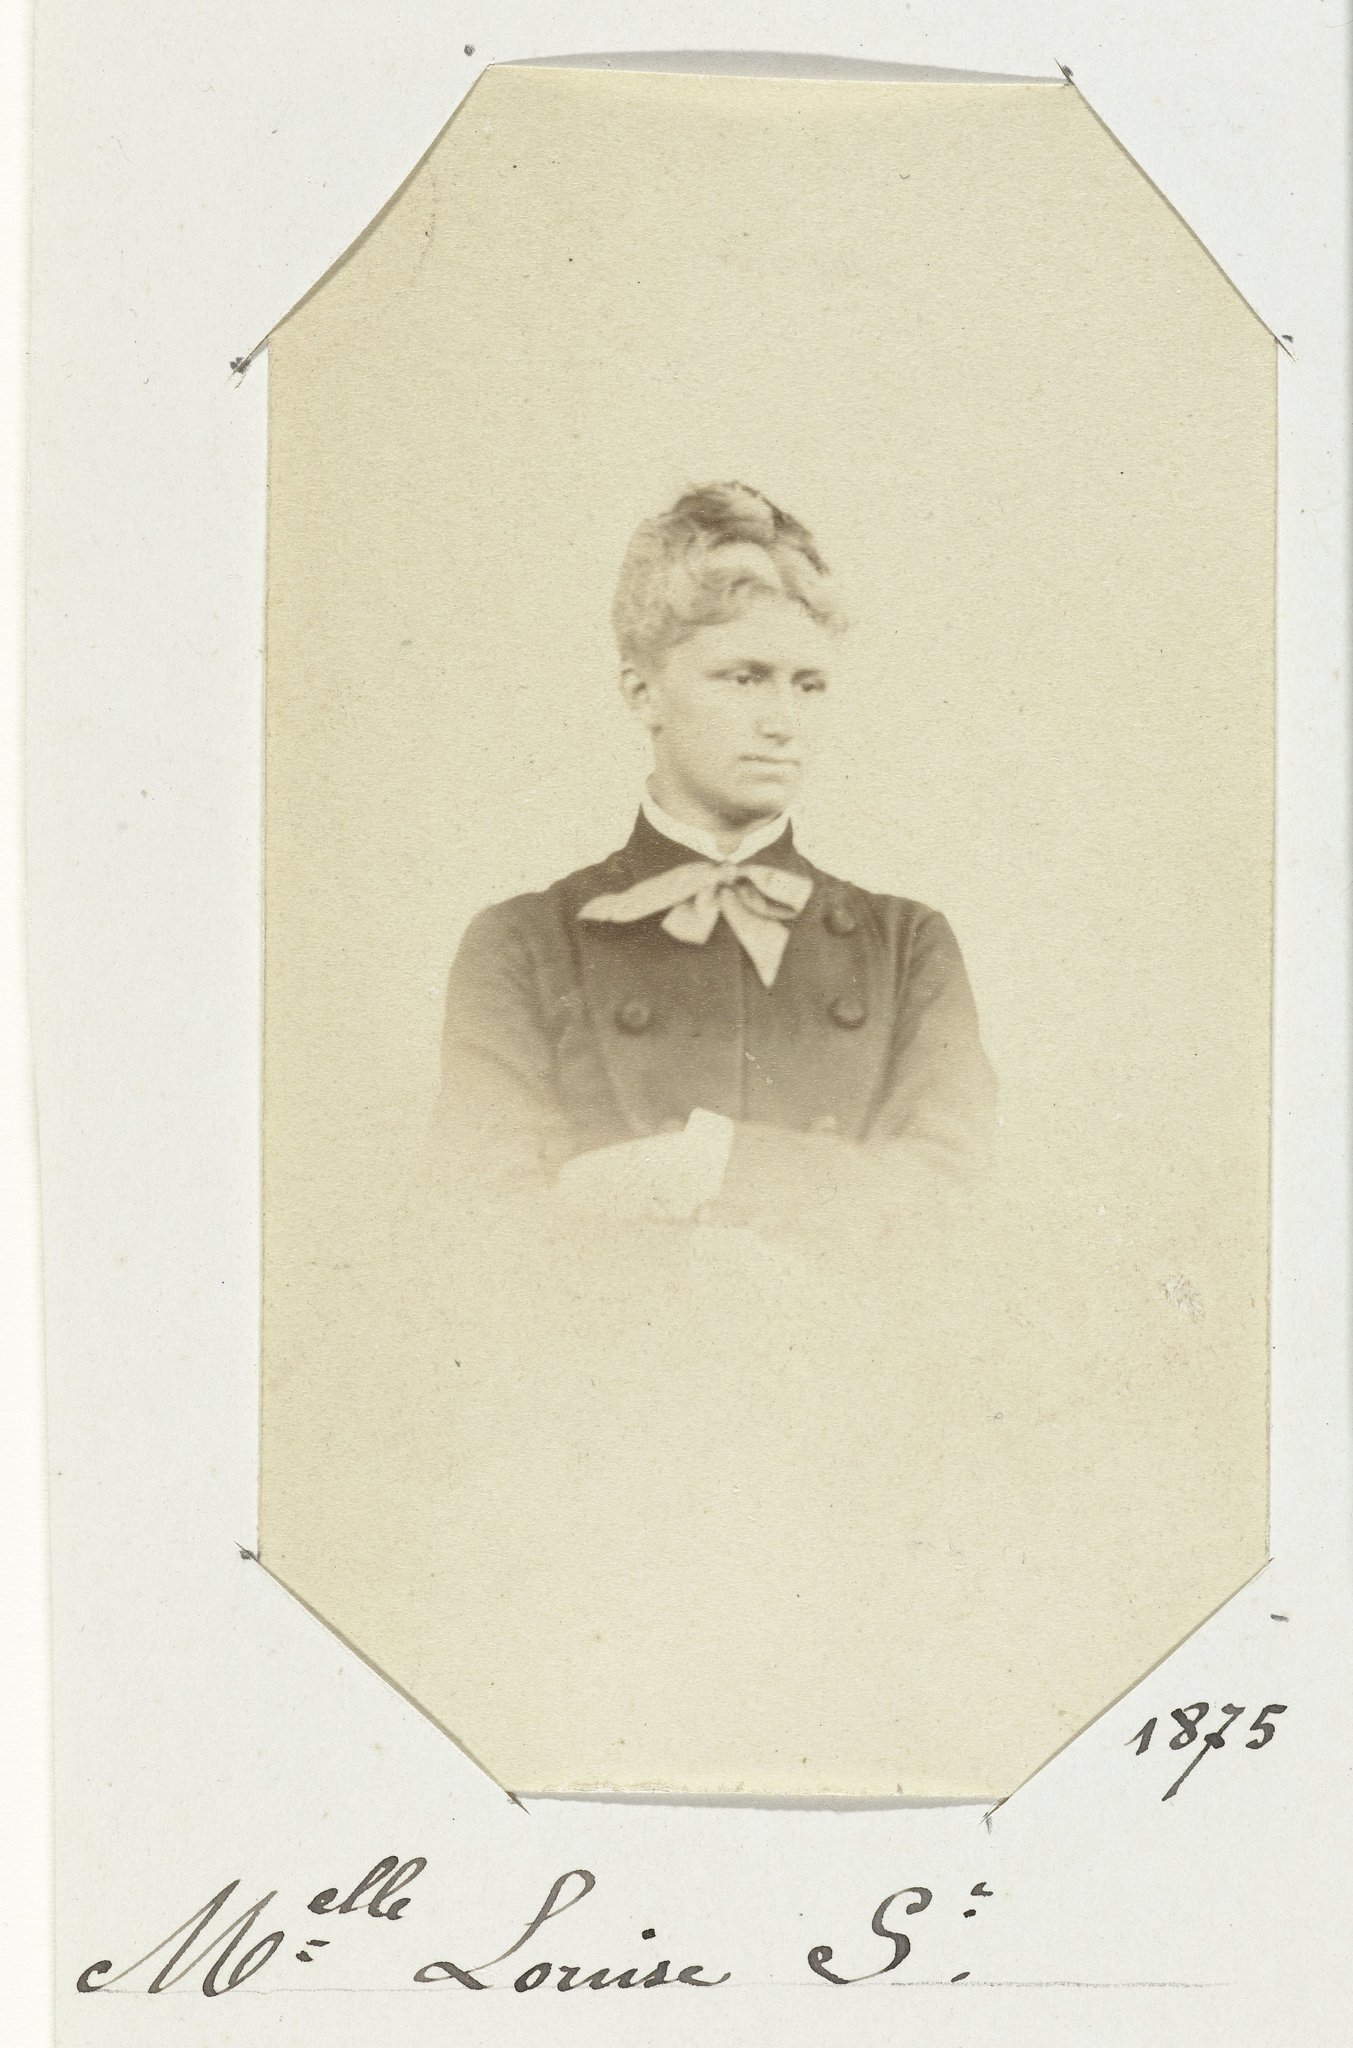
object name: photograph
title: M.elle Louise S.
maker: Anonymous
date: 1875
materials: paper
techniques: albumen print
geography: france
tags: adult woman, historical persons not known by name - bb - woman, france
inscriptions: number: ‘1875’, inscription: ‘M.elle Louise S. 1875’